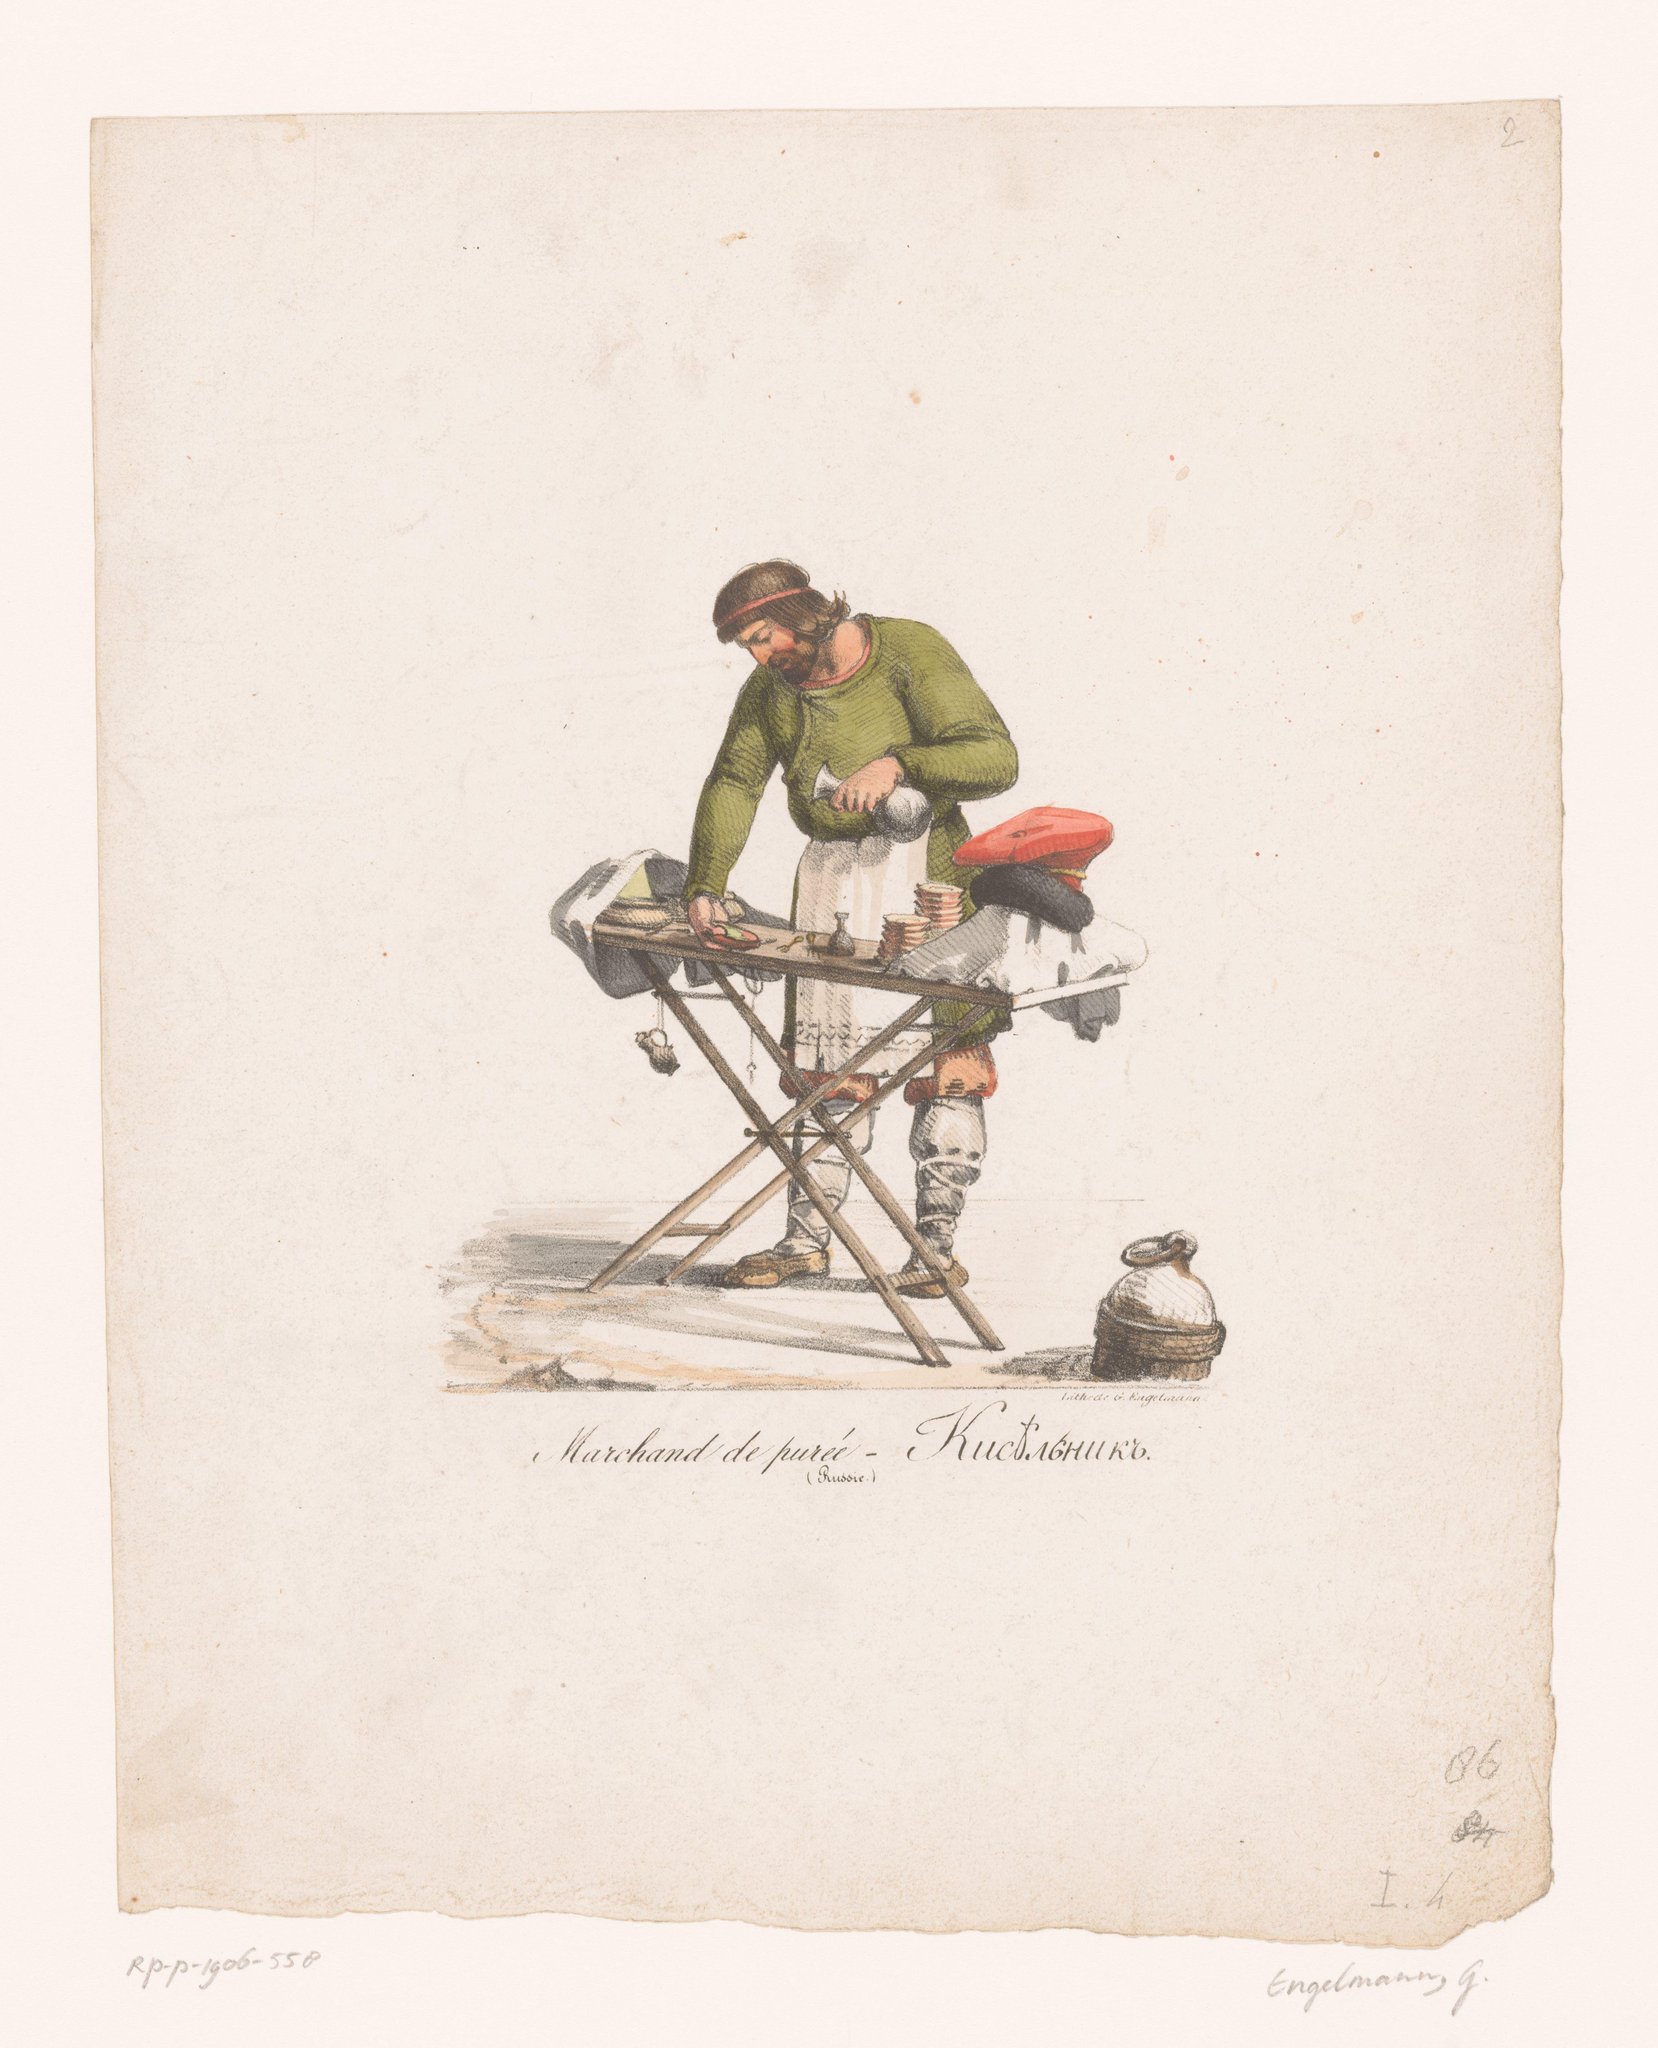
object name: print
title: Russische verkopers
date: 1816-1839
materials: paper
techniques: hand coloring, lithograph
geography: paris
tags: street-trader, human races; peoples; nationalities, europeans (with name)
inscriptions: collector's mark: Lugt 2228a